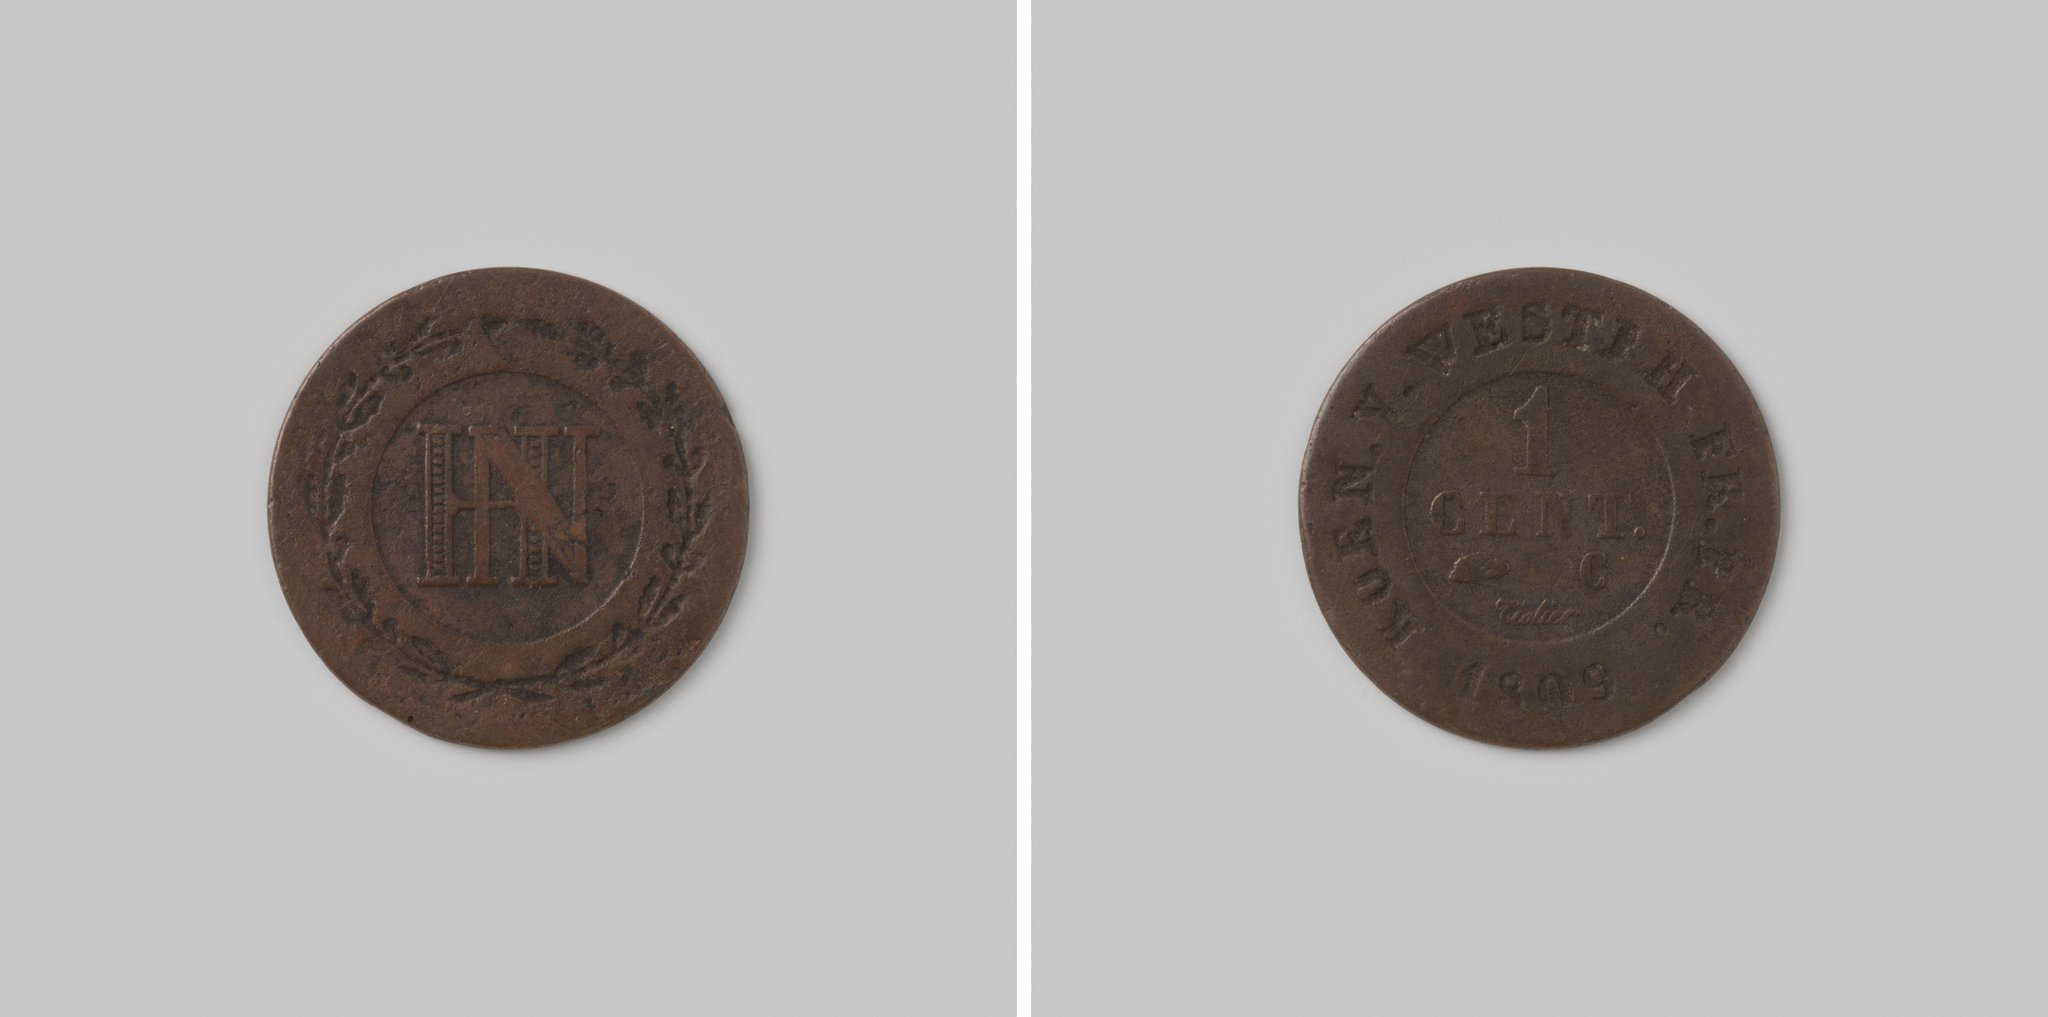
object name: centime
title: Centime uit het koninkrijk Westfalen van Jérome Napoléon, 1809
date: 1809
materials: copper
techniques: striking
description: Koperen munt. Voorzijde: binnen lauwerkrans monogram van de koning. Keerzijde: waarde-aanduiding in twee regels. Rechts daaronder letter C [=Kassel]. Jaartal in omschrift onderaan. Gladde rand.